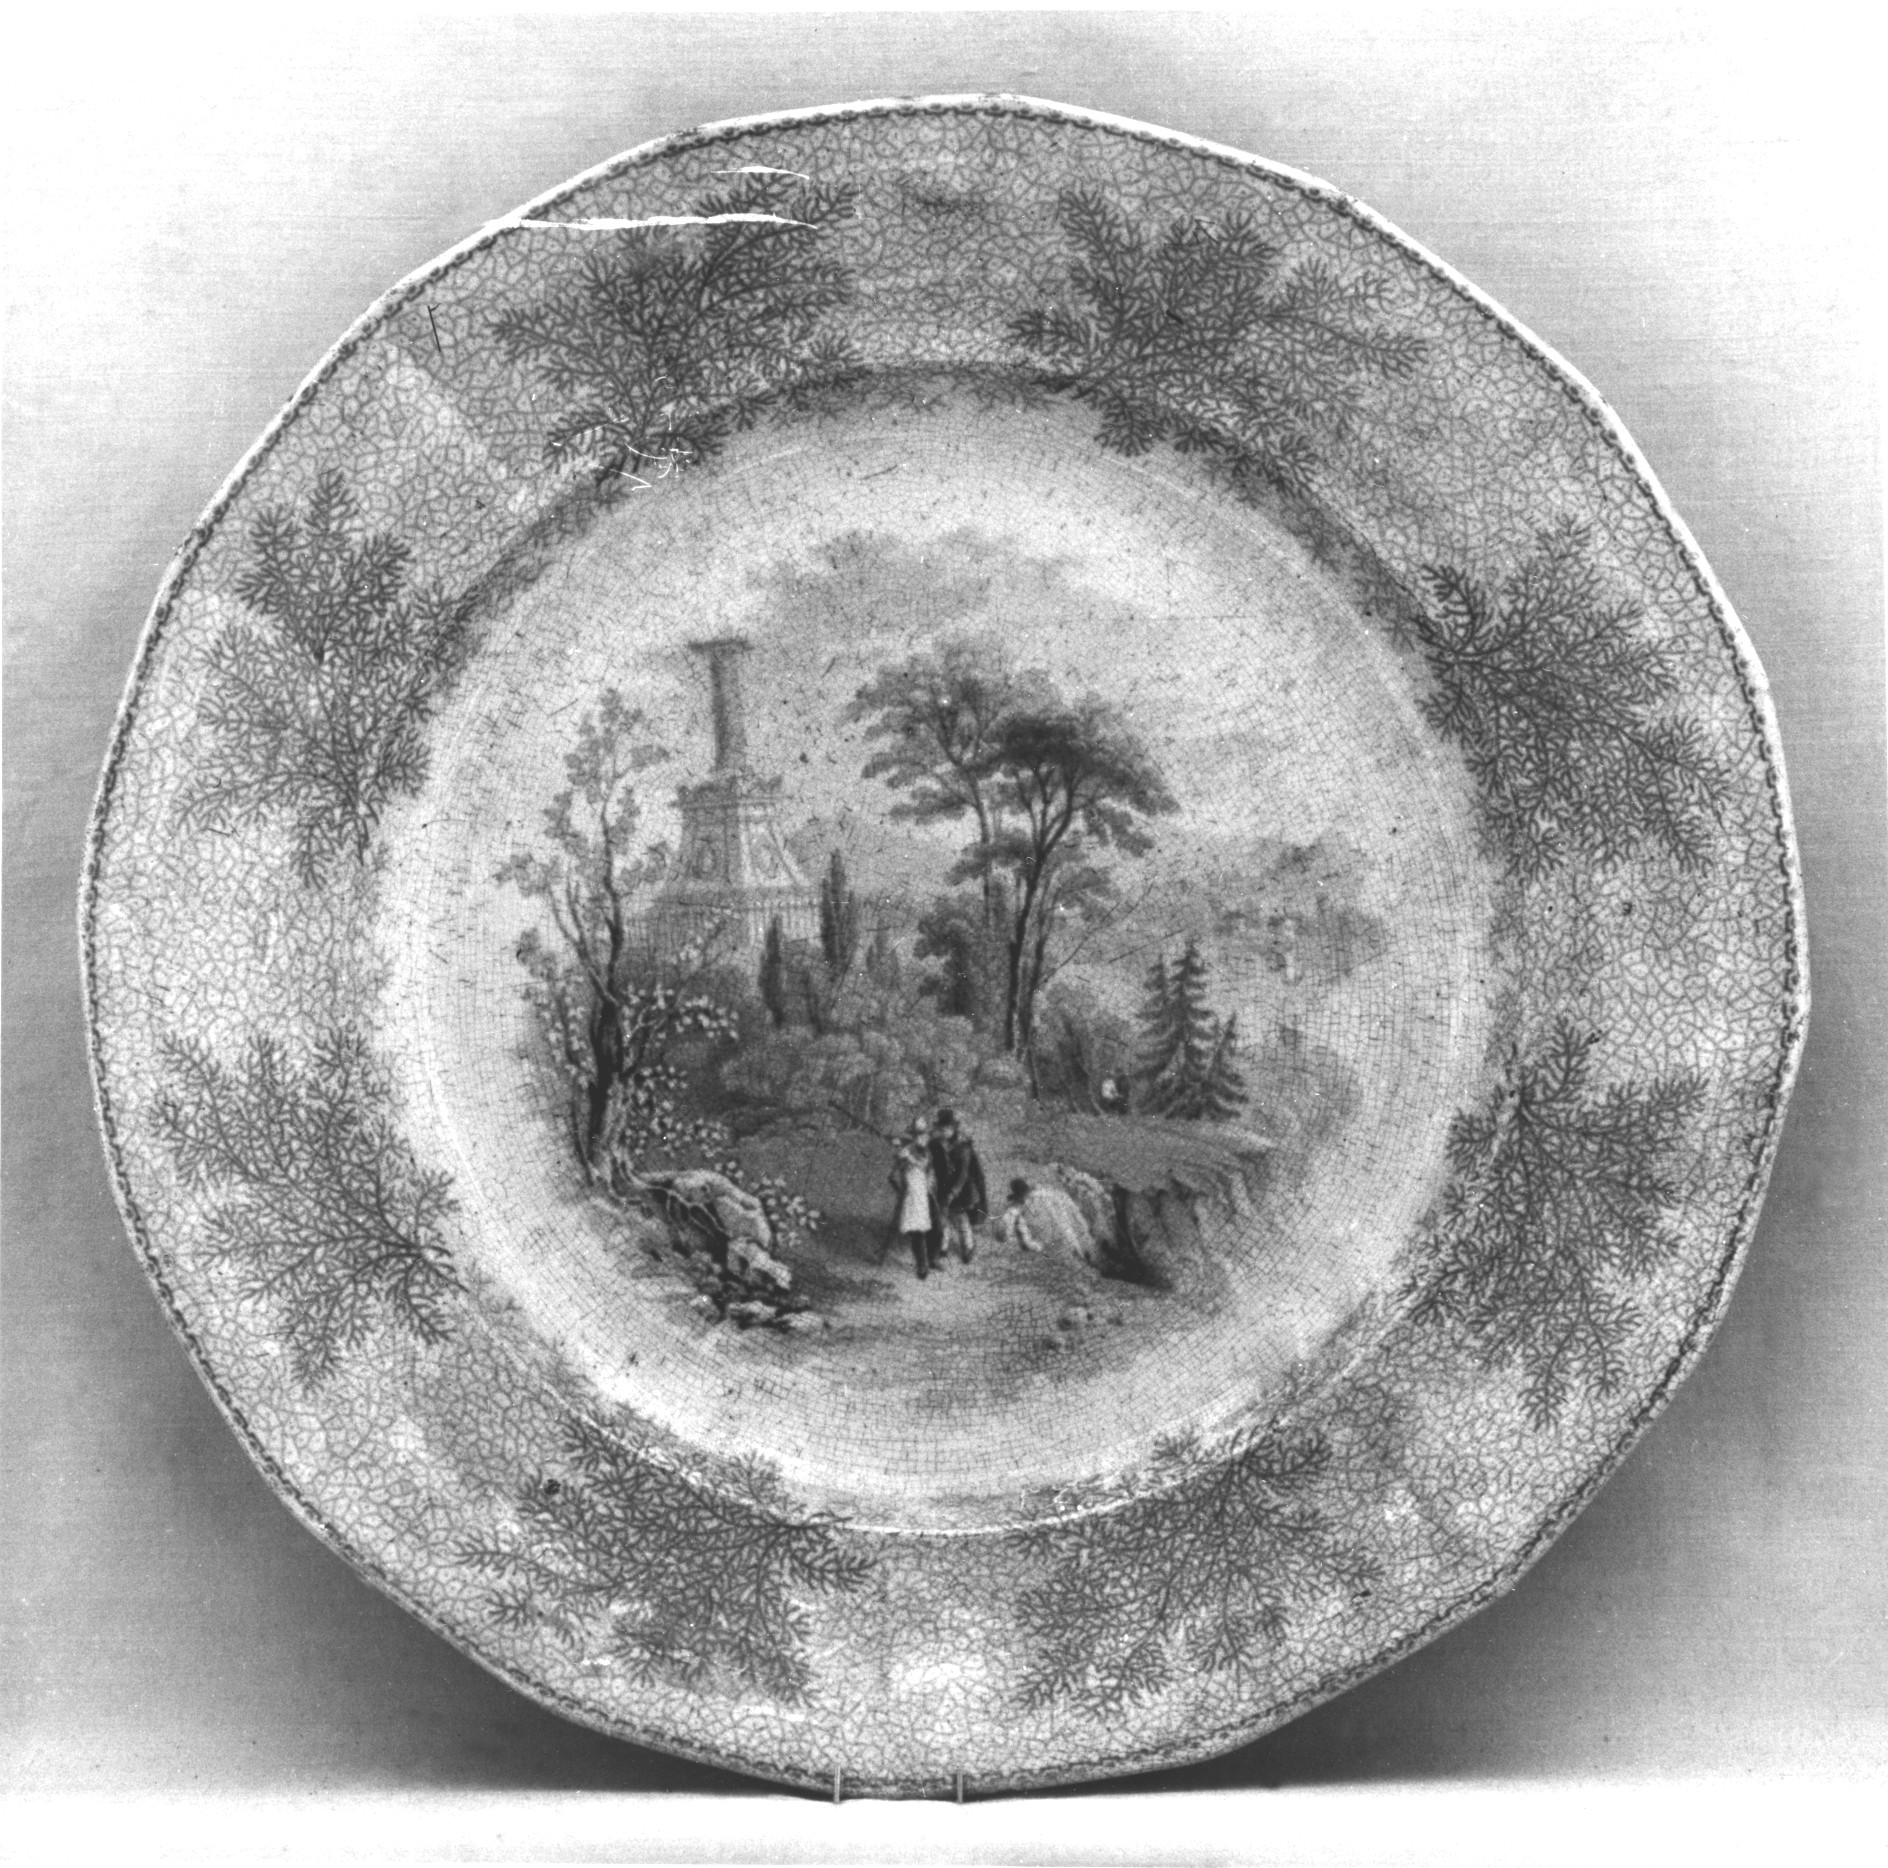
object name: plate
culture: british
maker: william ridgway, son & co.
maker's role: maker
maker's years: 1833-1848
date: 1844-1846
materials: earthenware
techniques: transfer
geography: england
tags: landscapes